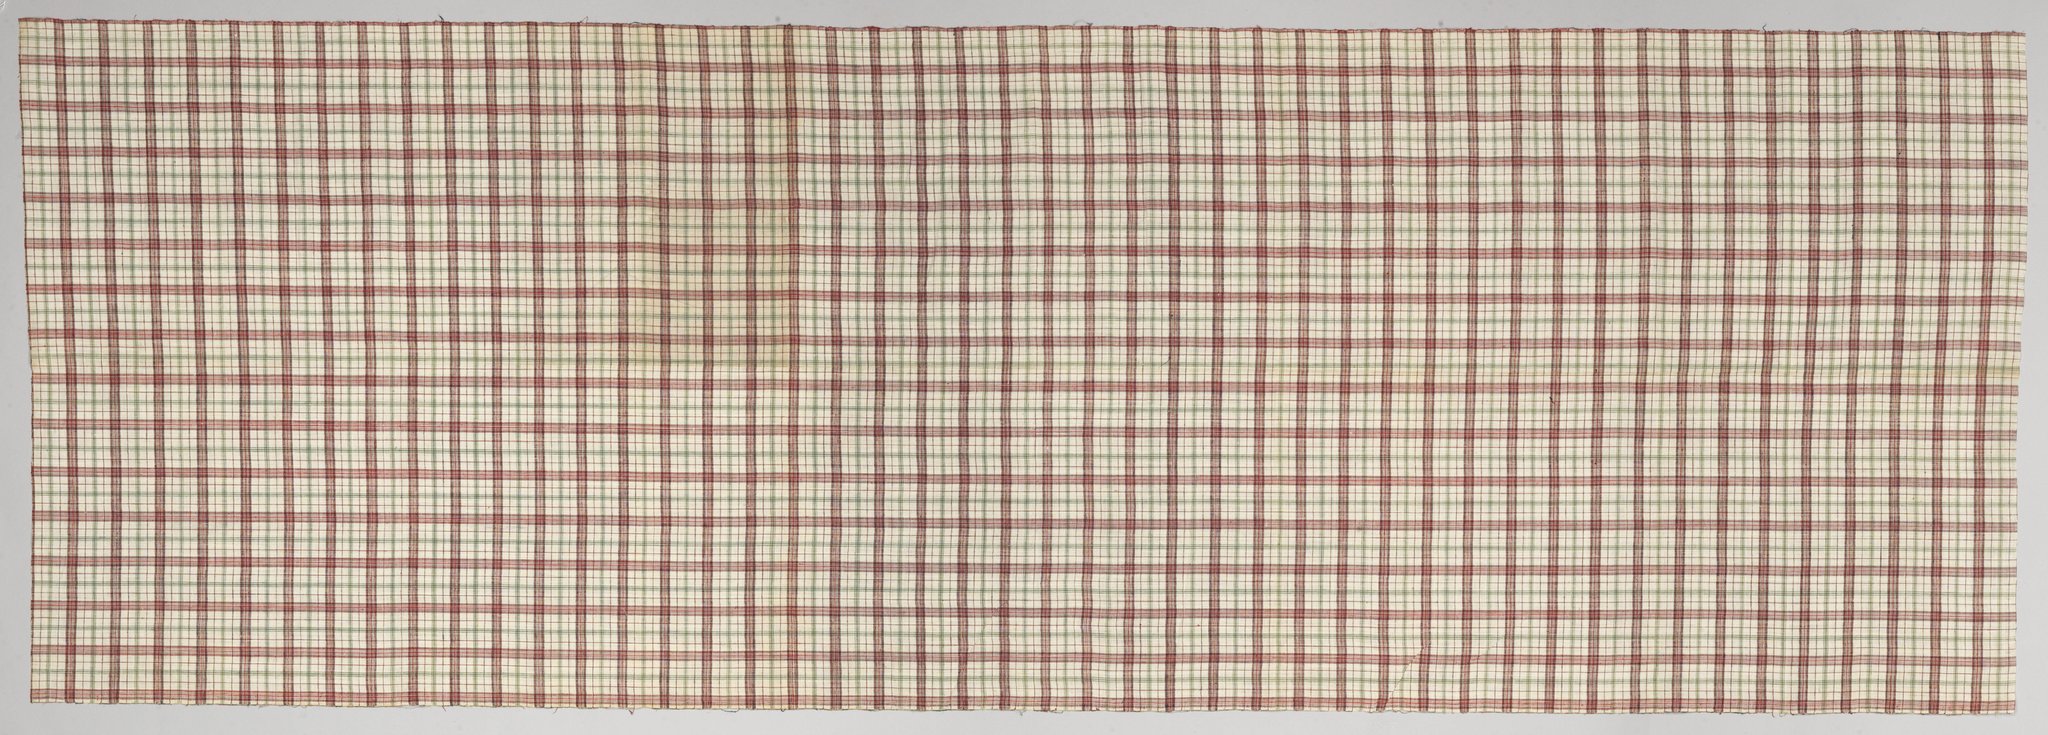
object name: fragment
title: Fragment droogdoeken met groene ruiten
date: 1800-1900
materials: cotton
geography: england